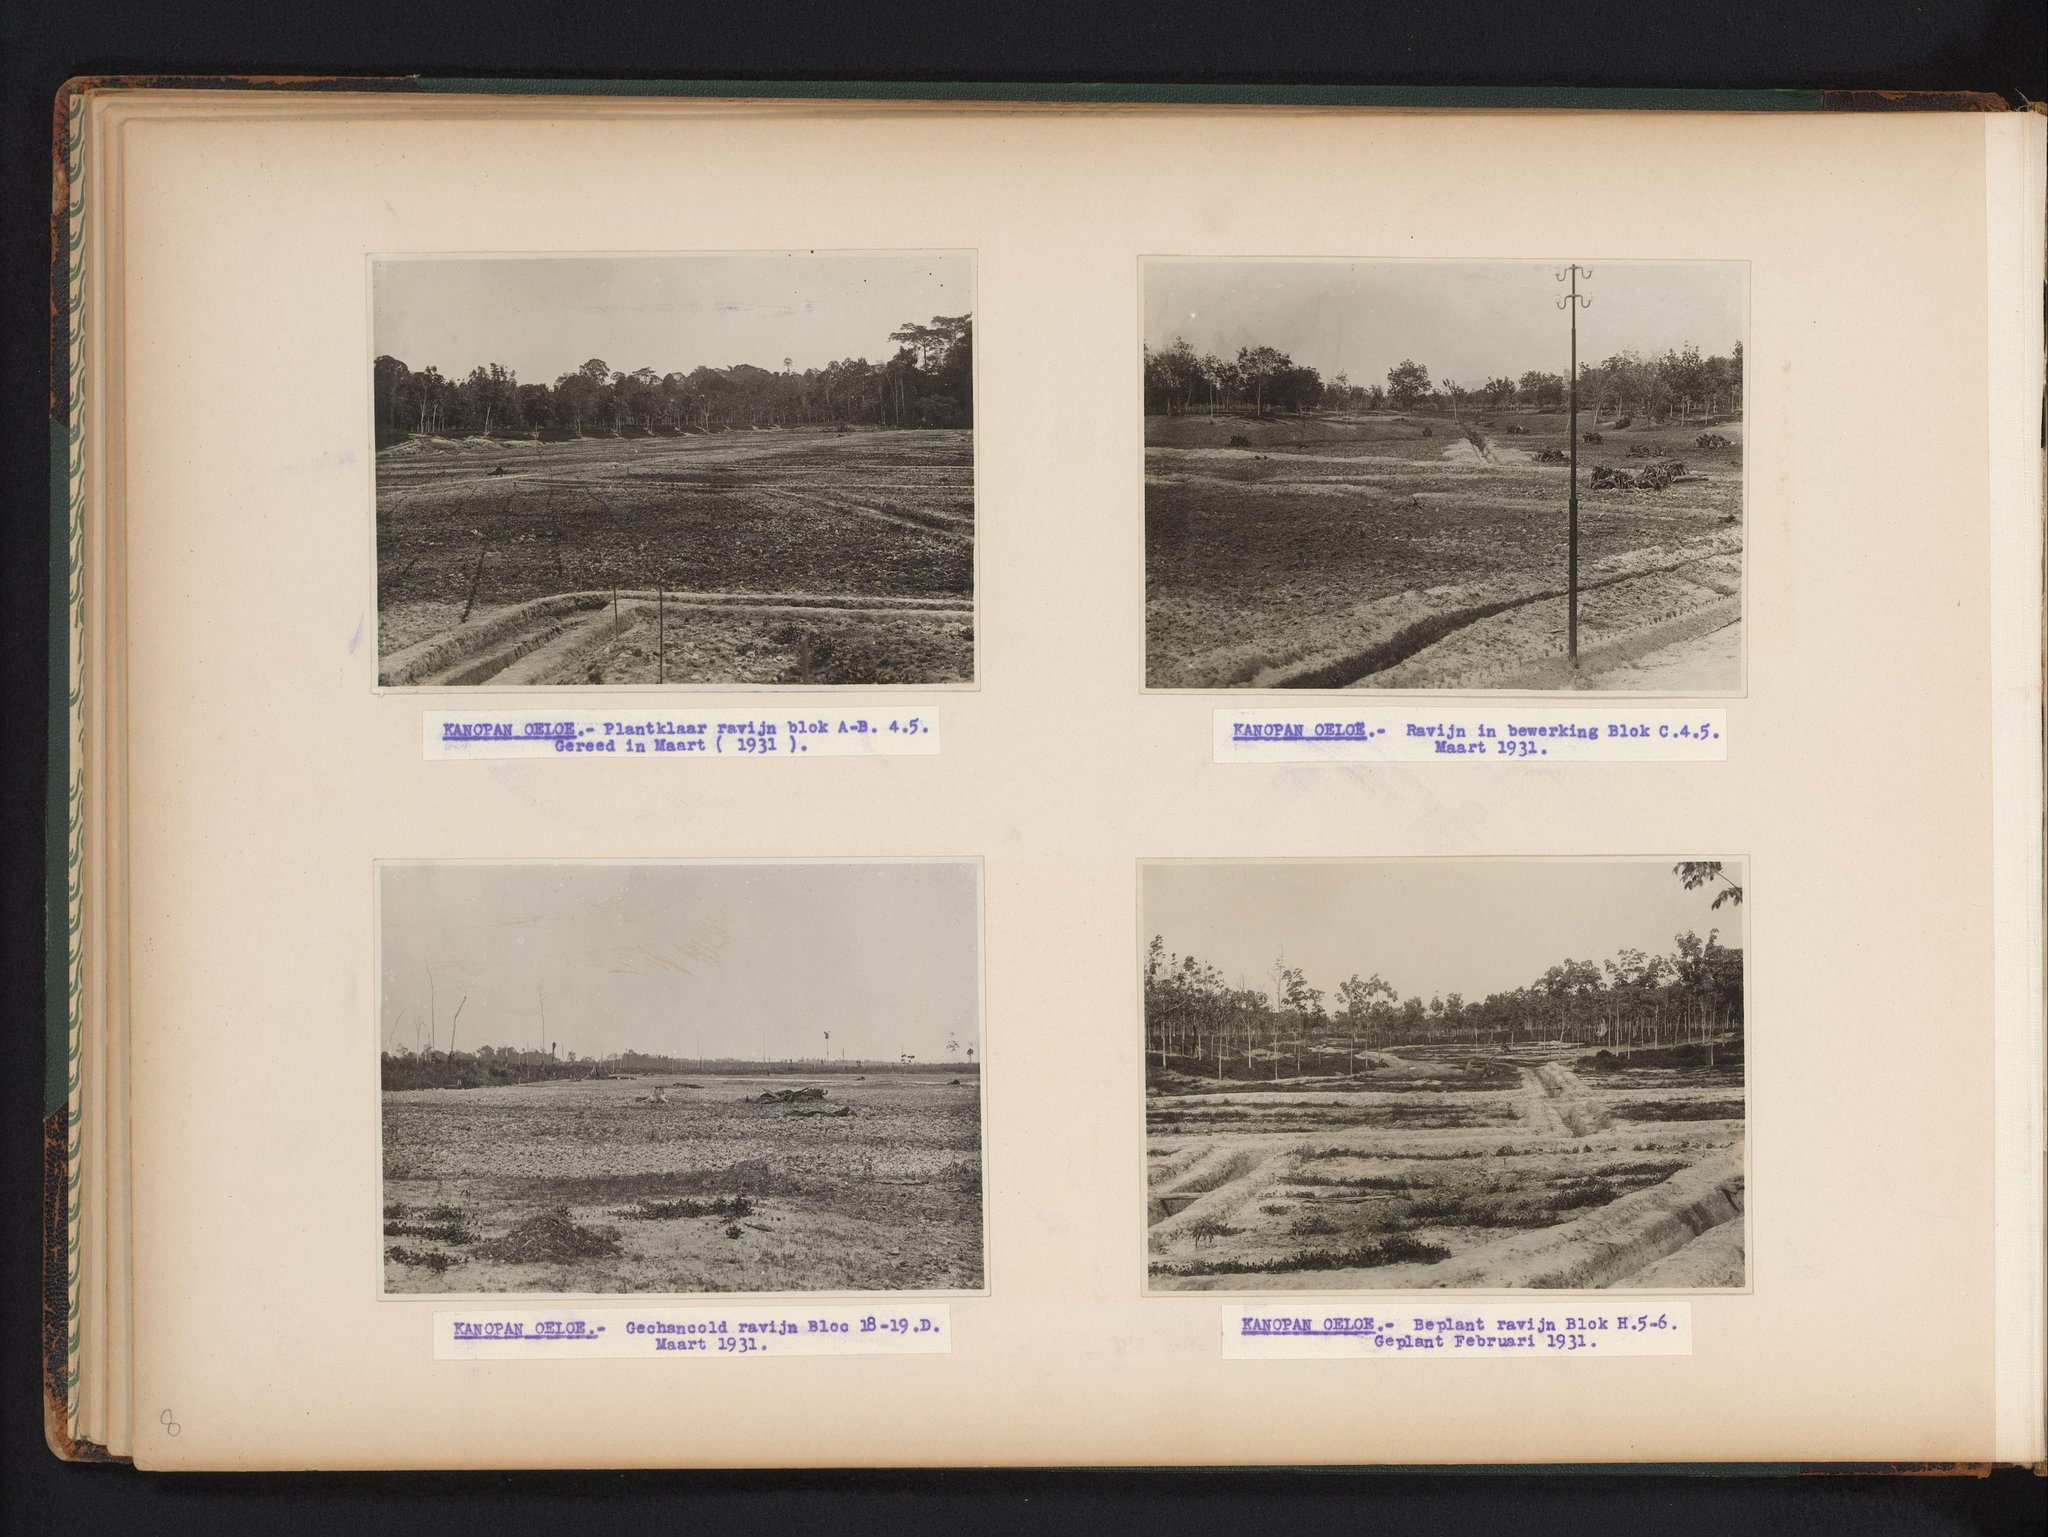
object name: photograph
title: Ontginning en aanplant in ravijnen op Kanopan Oeloe, 1931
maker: Anonymous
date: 1903-1931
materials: cardboard, photographic support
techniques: gelatin silver print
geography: sumatra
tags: plantation, (non-fruit) products of plants or trees: rubber, sumatra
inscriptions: inscription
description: Blad met vier foto's van ontginning en beplanting van ravijnen op Kanopan Oeloe, maart 1931. Onderdeel van het fotoalbum over de plantages Leidong West en Kanopan Oeloe van de Cultuur Maatschappij Leidong West op Sumatra in de jaren 1925-1939.